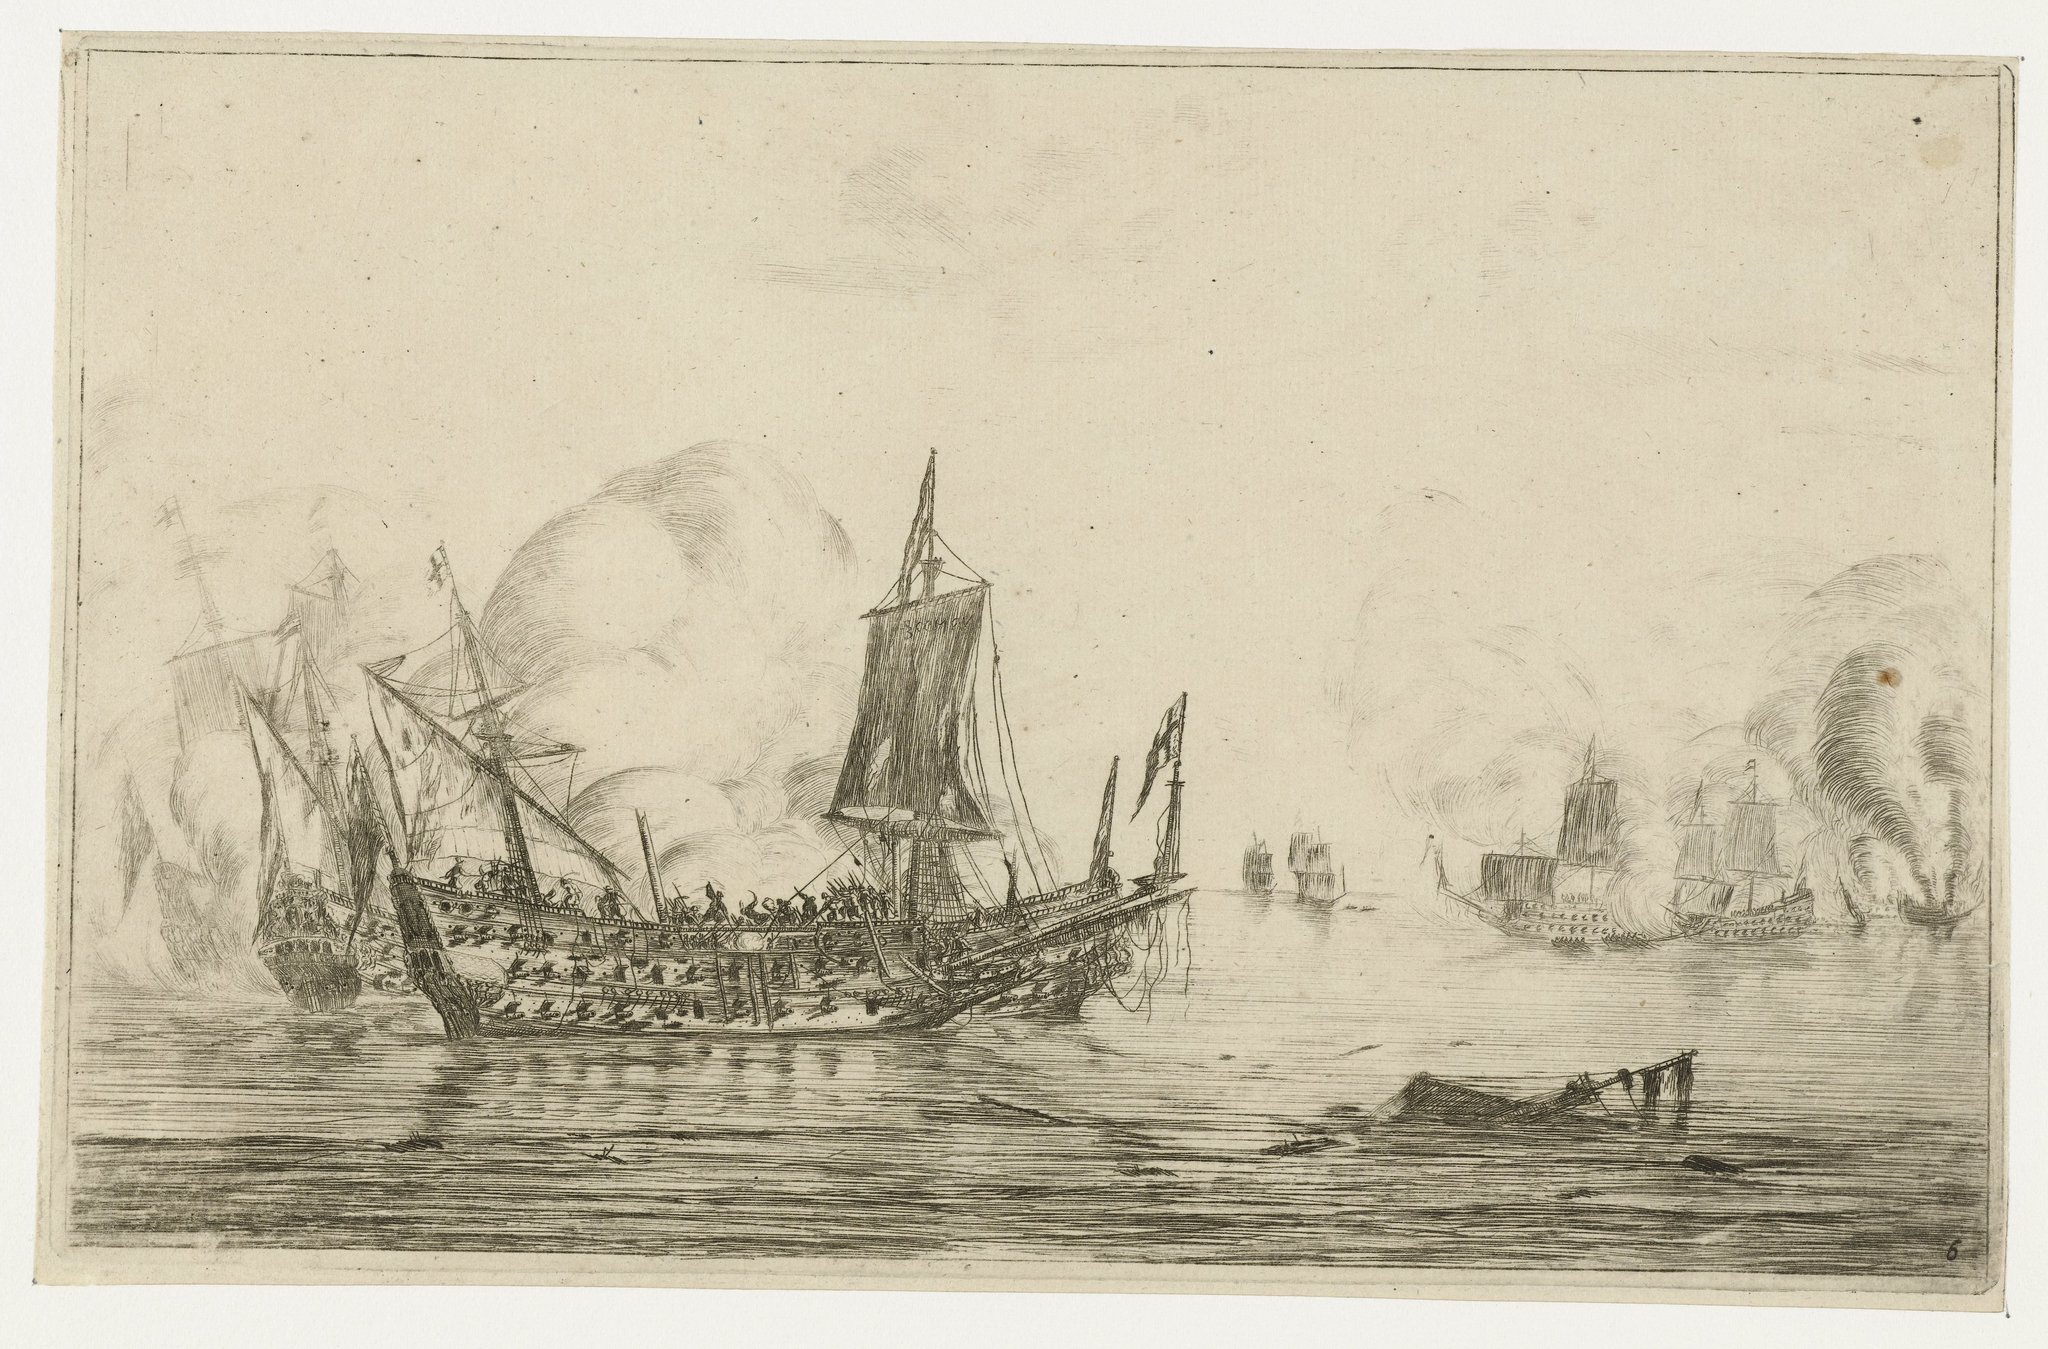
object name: print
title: Nieuwe Scheeps Batalien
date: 1652-1726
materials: paper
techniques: drypoint, etching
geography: netherlands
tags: warfare; military affairs (+ sailing-ships), battle, fighting in general (+ naval force)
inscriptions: collector's mark: Lugt 2228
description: Brandende schepen en een gevecht op een veroverd schip.